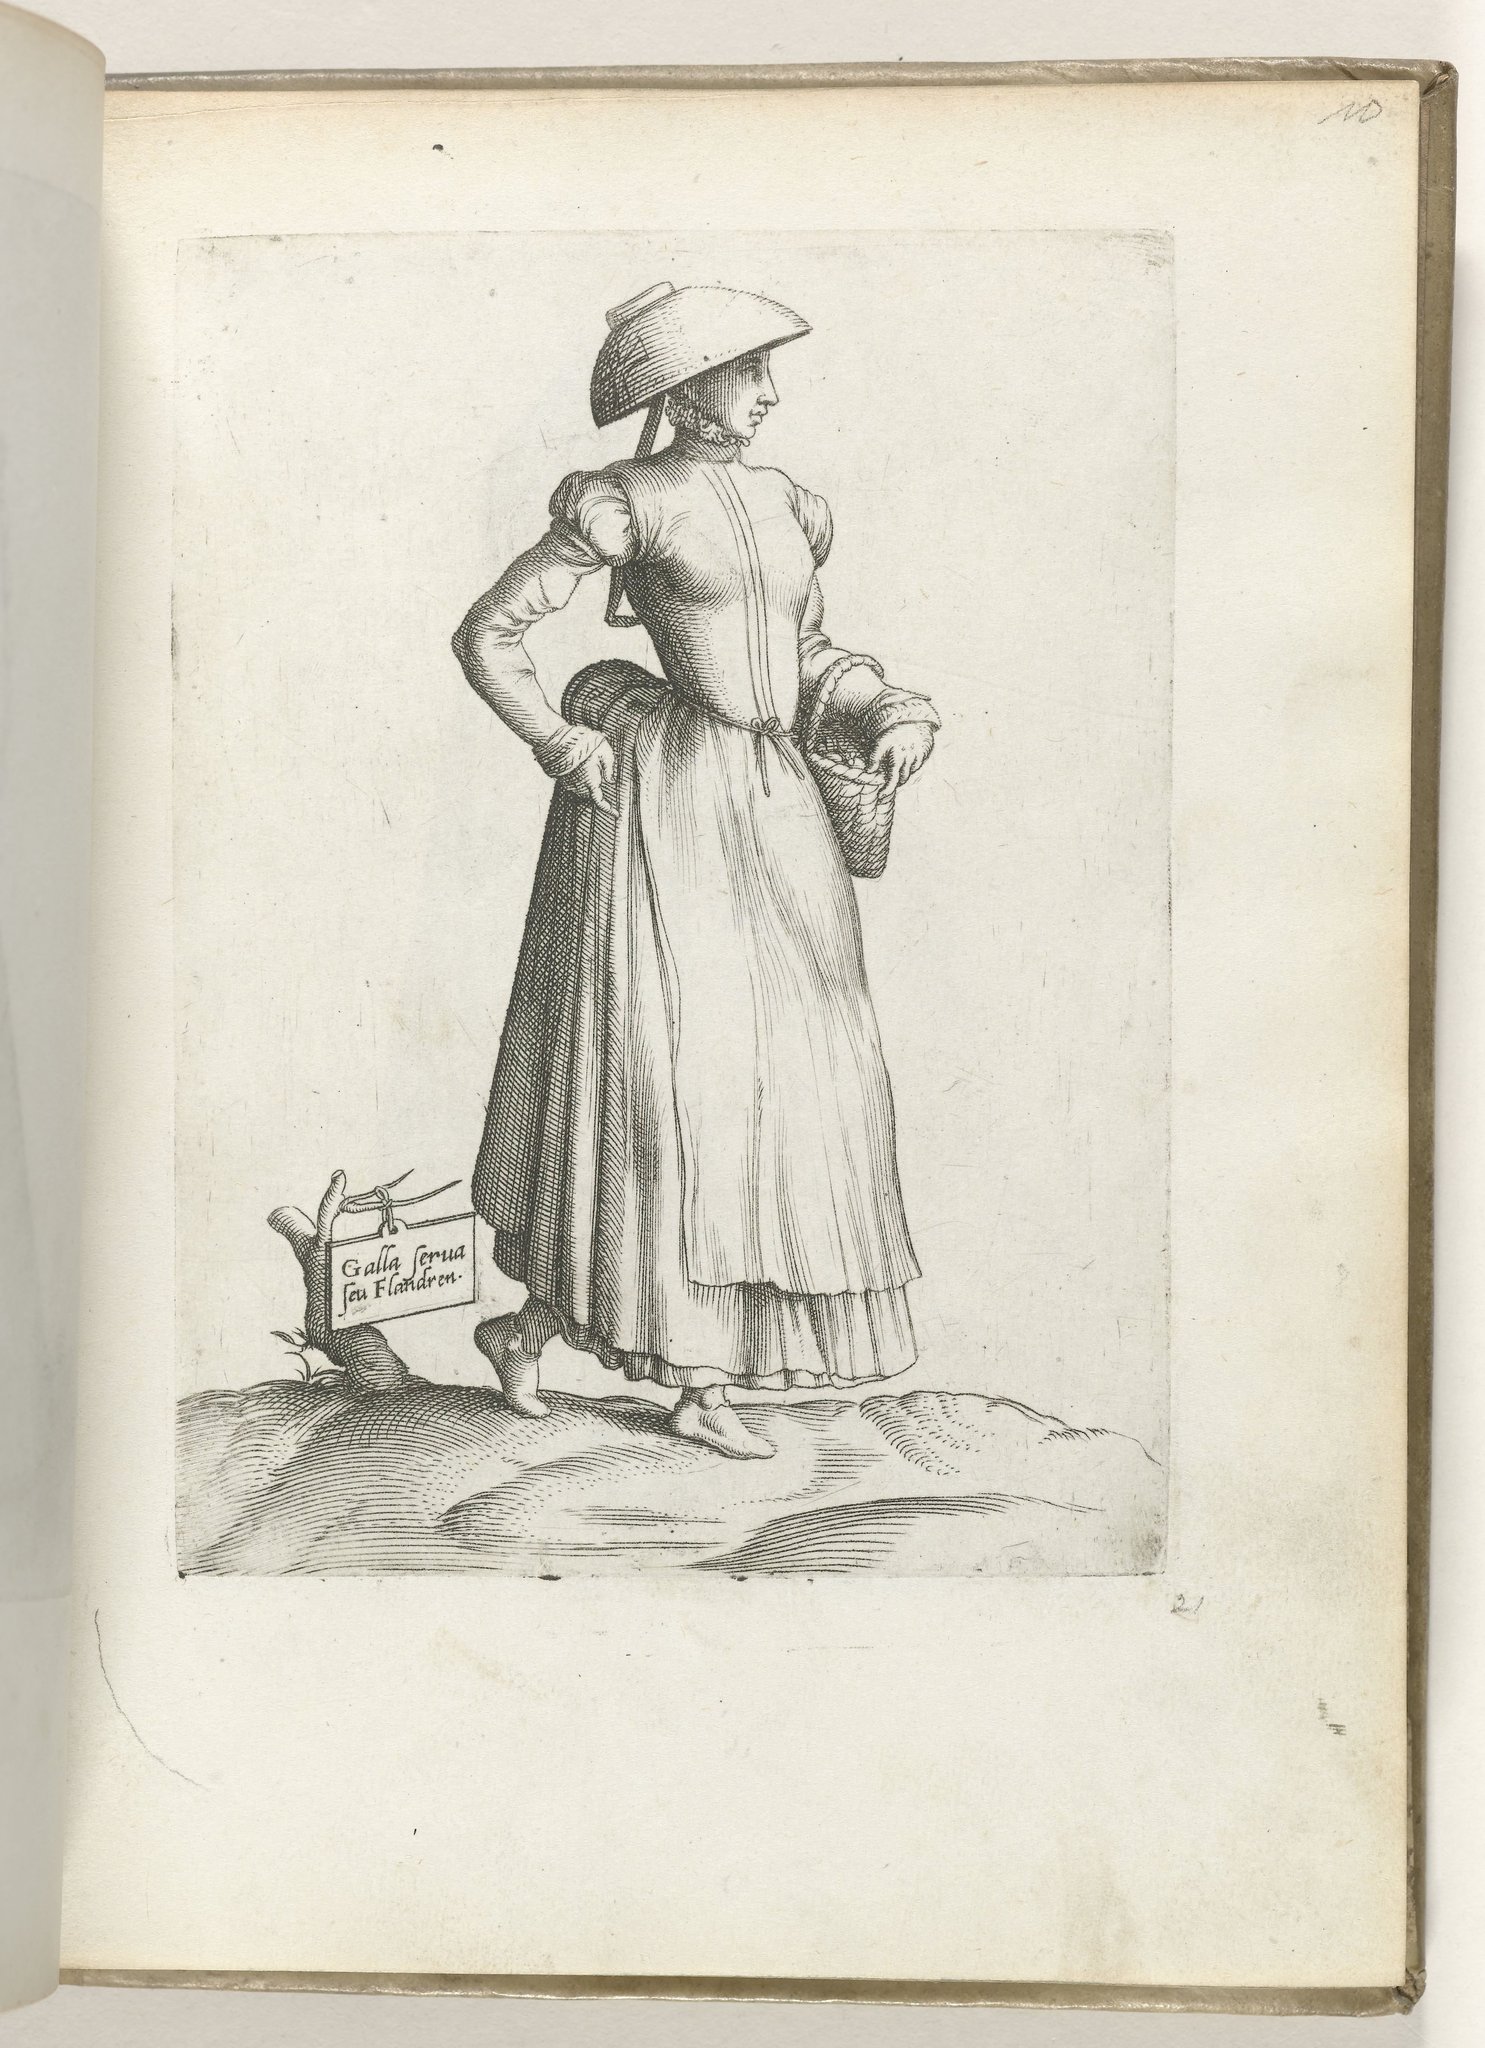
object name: costume print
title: Dienstbode uit Vlaanderen, gekleed volgens de mode van ca. 1550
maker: enea vico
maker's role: draughtsman, print maker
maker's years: 1523-1567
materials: paper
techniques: engraving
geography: venice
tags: fashion plates, head-gear: hat (+ women's clothes), maid ~ house personnel, apron (+ women's clothes)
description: Vrouw met mand aan de arm, naar rechts, ronde hoed op het hoofd. Prent uit album 'Diversarum gentium nostrae aetatis habitus'.